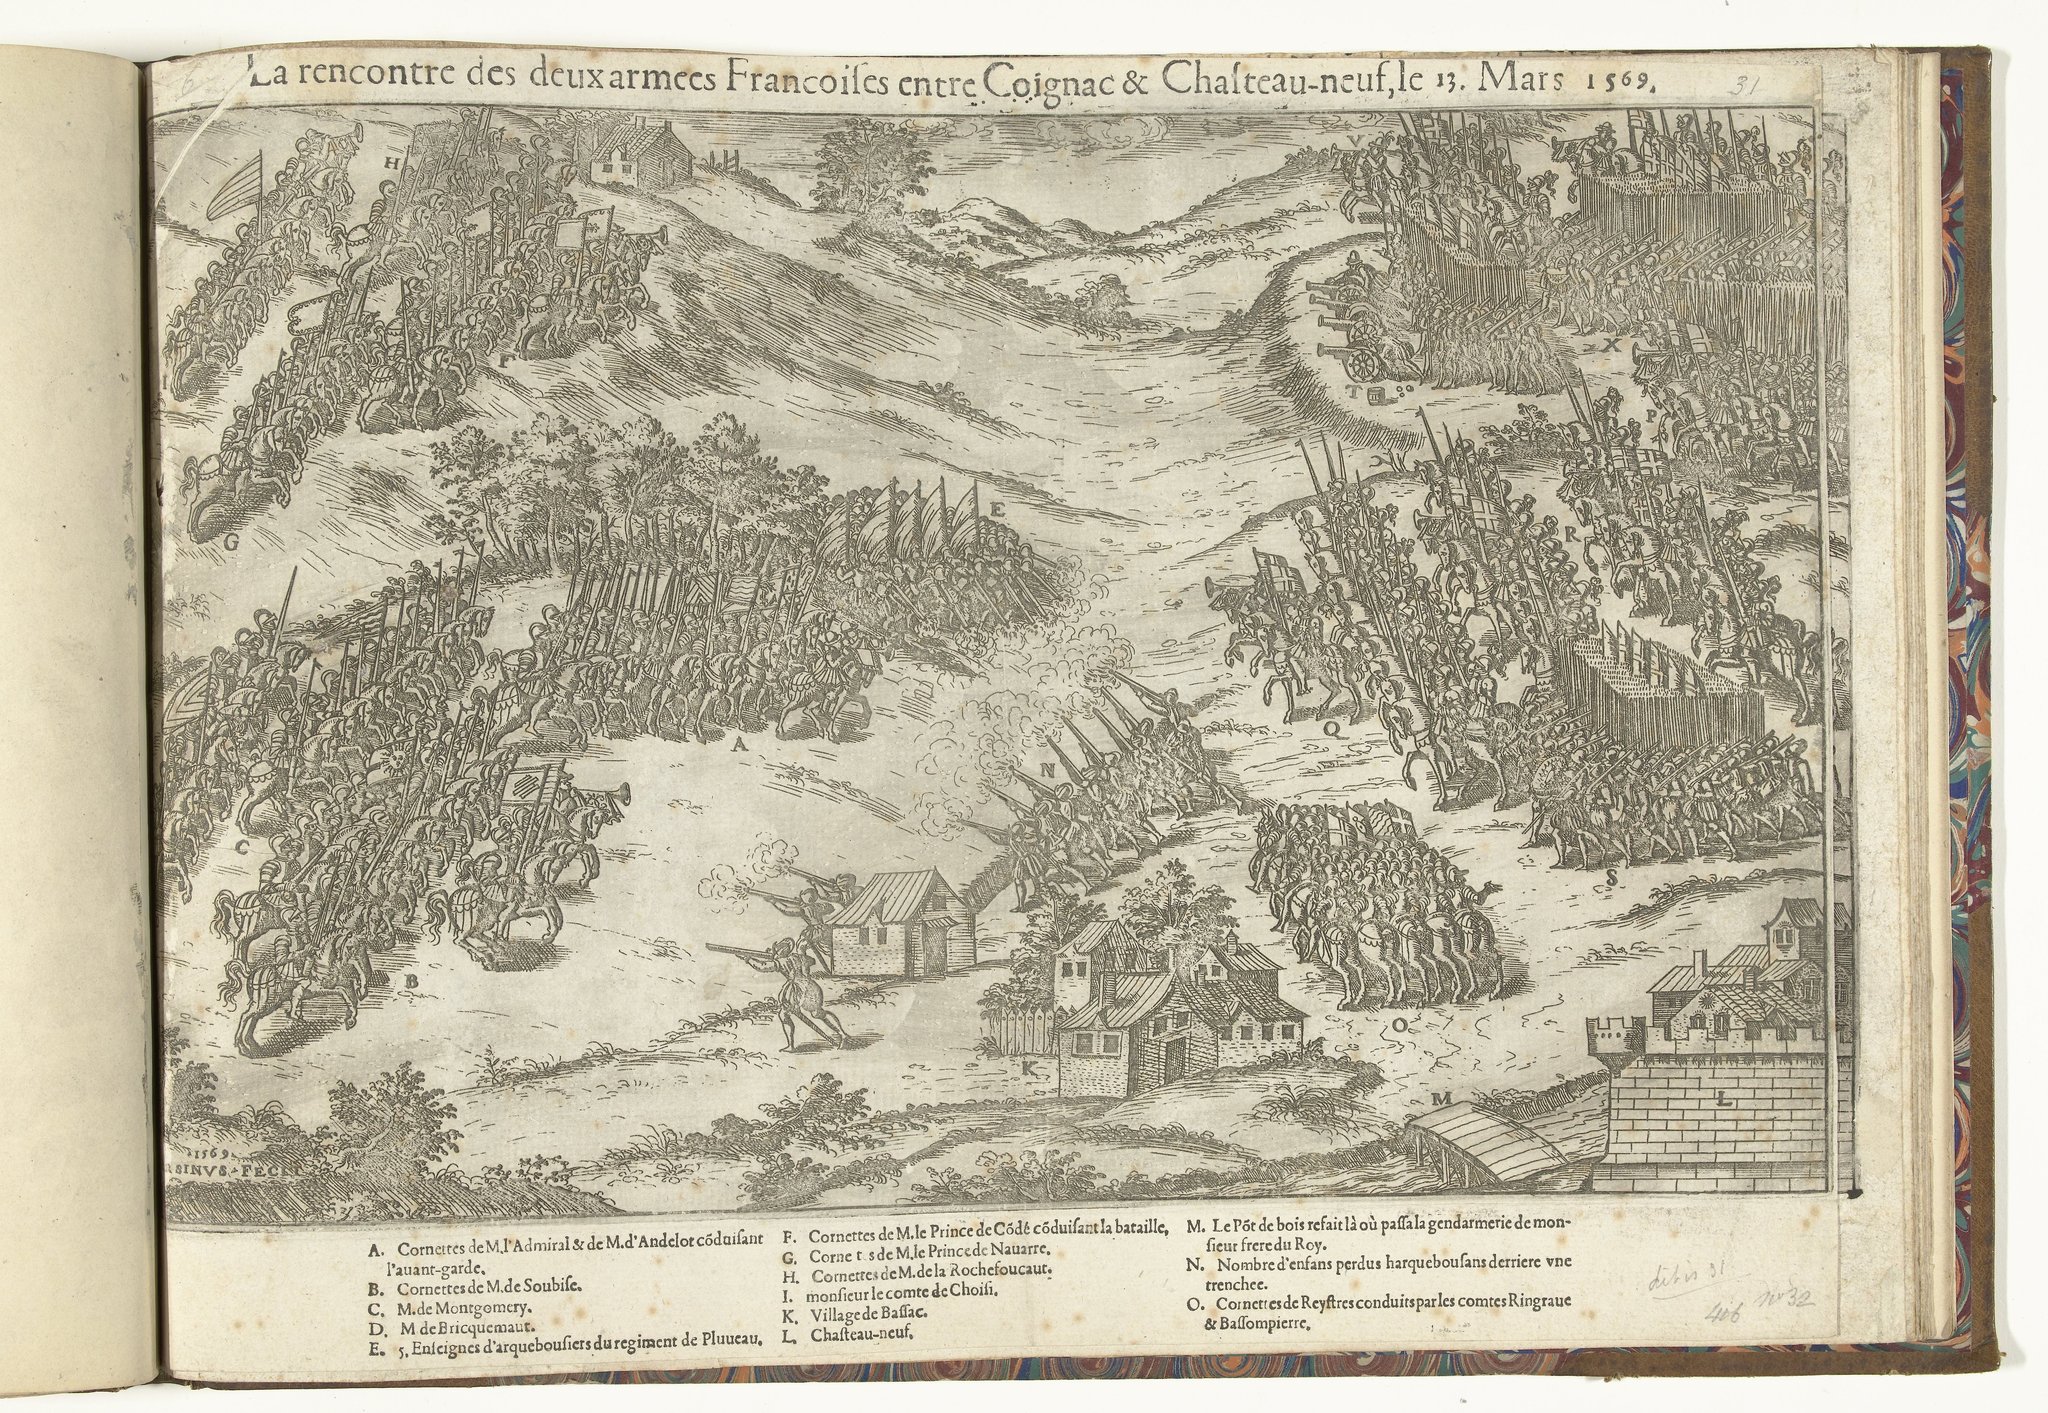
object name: print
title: La rencontre des deux armees Francoises entre Coignac & Chasteau-neuf, le 13. Mars 1569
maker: jean perrissin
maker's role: print maker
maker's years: 1536-1611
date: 1569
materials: paper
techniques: etching, letterpress printing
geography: france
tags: battle, fighting in general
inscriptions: date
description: Treffen van de legers bij Jarnac, 13 maart 1569. Gezicht op het slagveld. In het onderschrift de legenda A-O in het Frans. Ongenummerd.